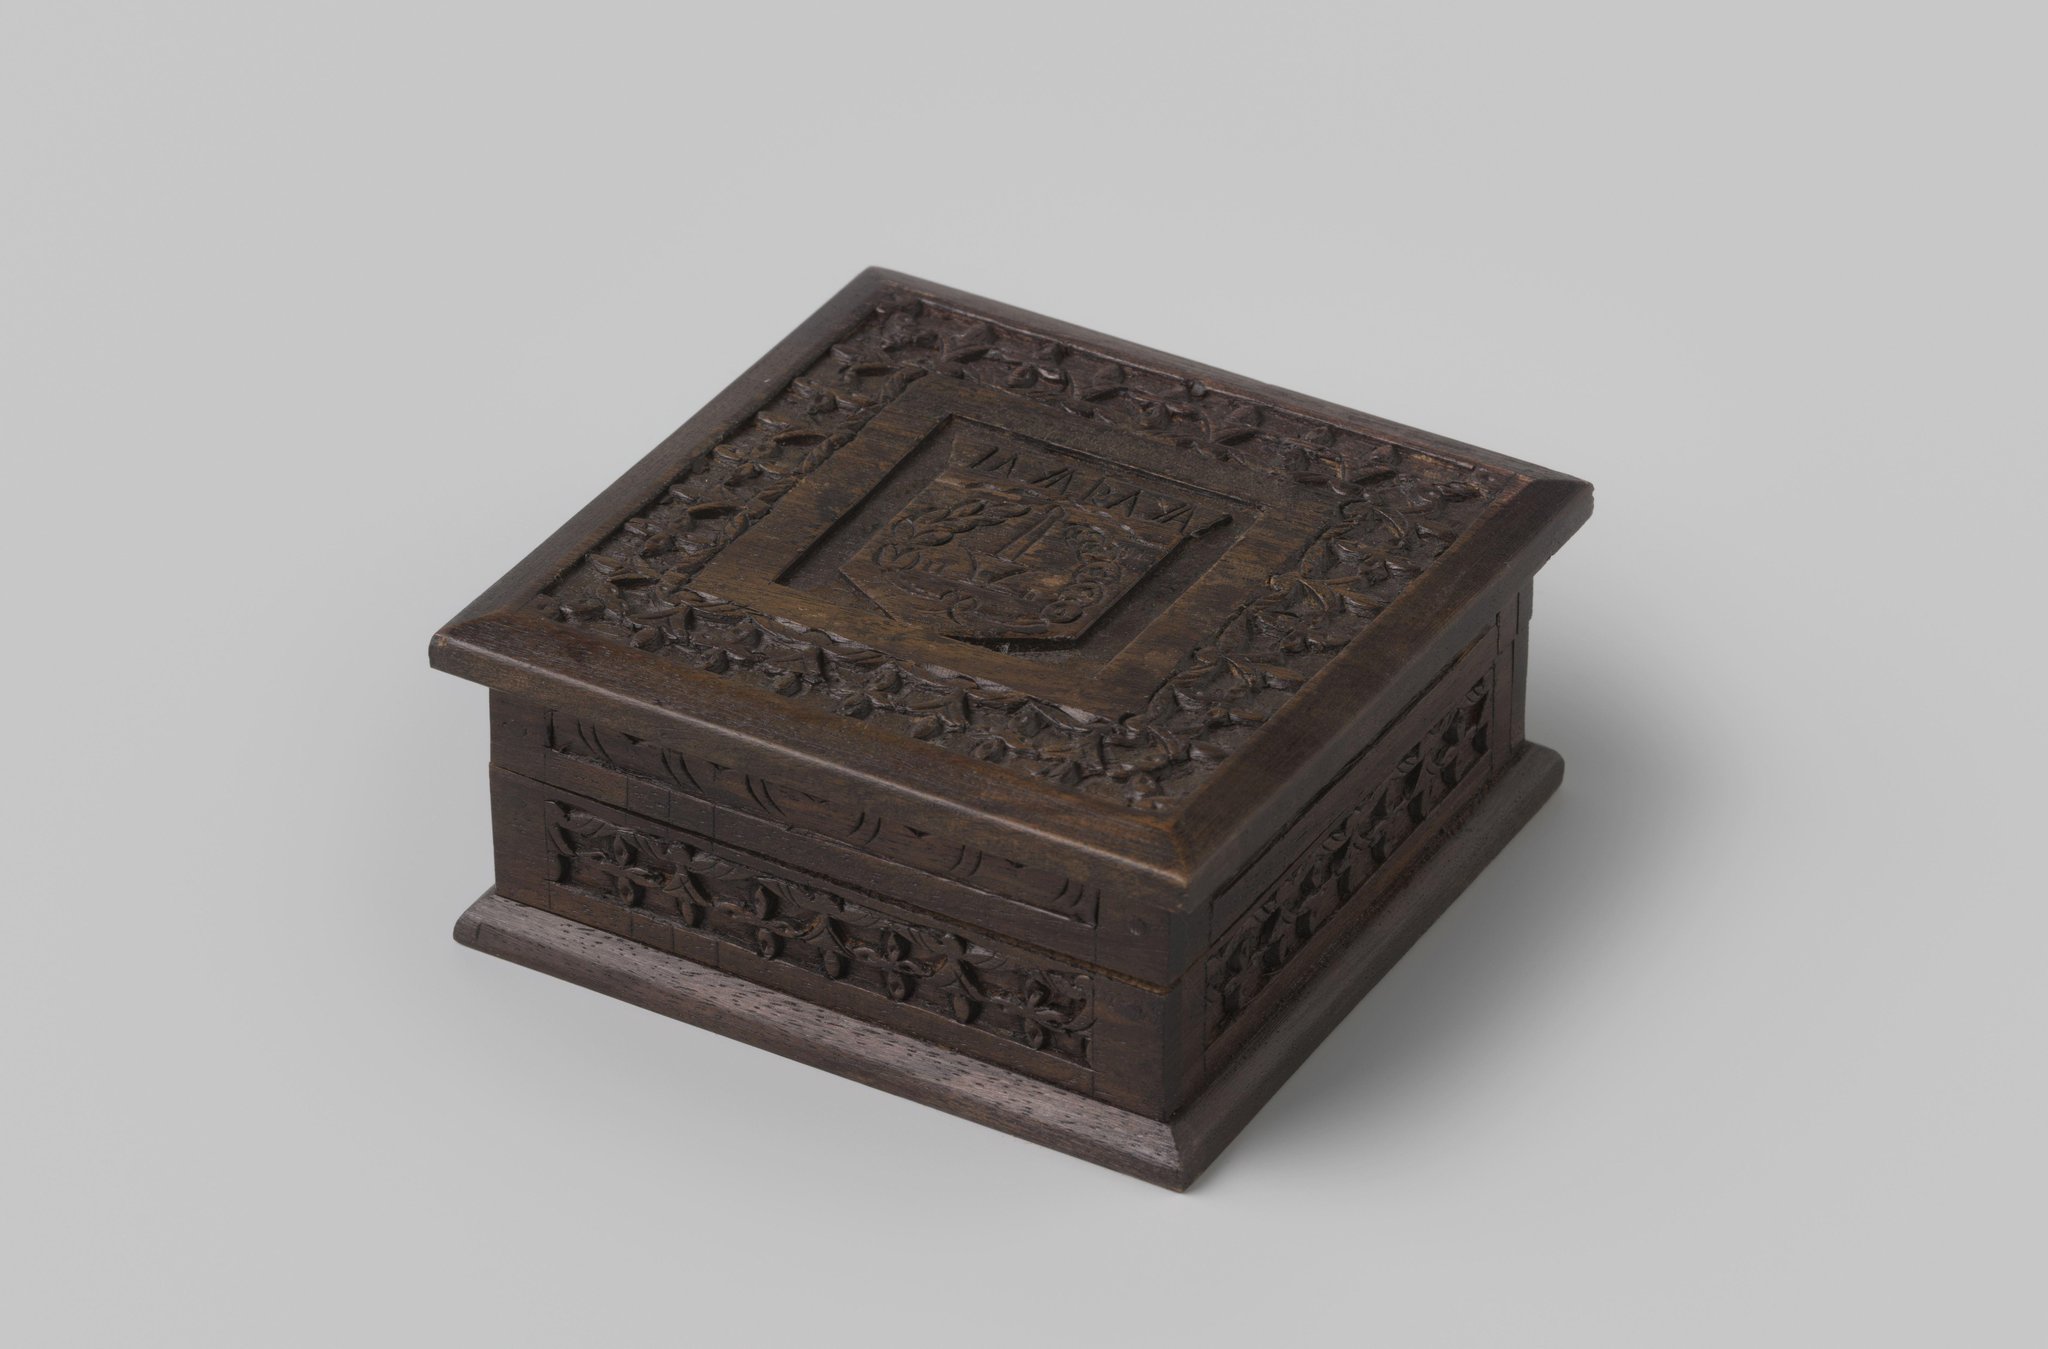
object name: box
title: Houten doosje behorend bij een erepenningvan het gewest Jakarta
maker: Anonymous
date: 1975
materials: wood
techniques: cutting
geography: indonesia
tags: jakarta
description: Houten vierkanten doos behorend bij een erepenning. Op de doos staat Jaya Raya temidden van uitgesneden lelies. Binnenzijde van de deksel en het doosje bestaat uit rood fluweel met een uitsparing voor de penning.